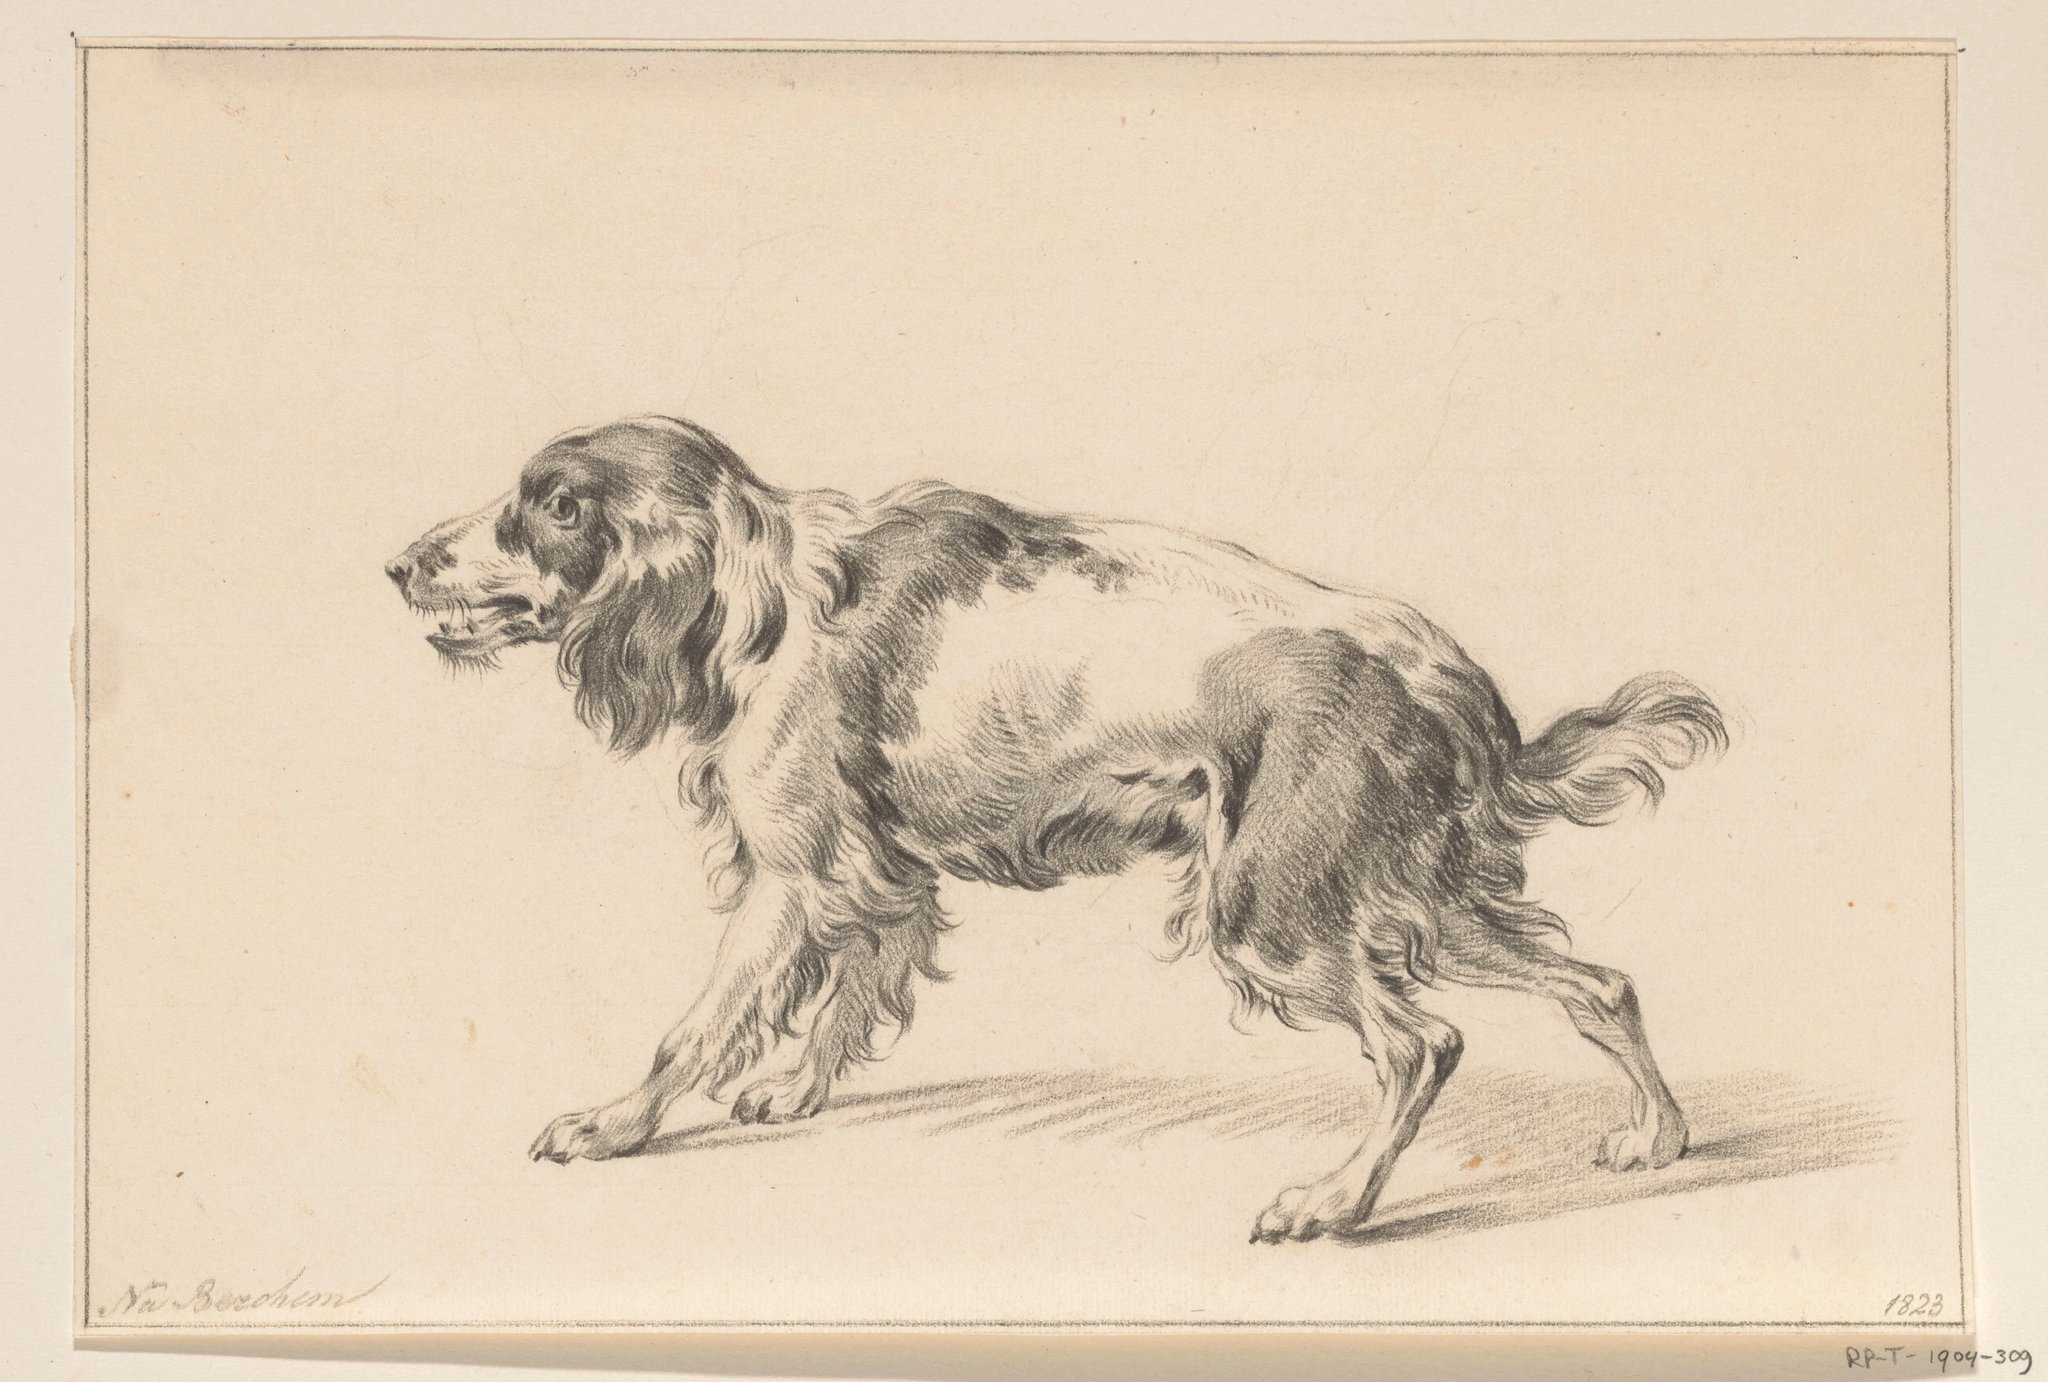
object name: drawing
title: Staande blaffende hond, naar links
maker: jean bernard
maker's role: draughtsman, print maker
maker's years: 1765-1833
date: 1823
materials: chalk, paper, pencil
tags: dog